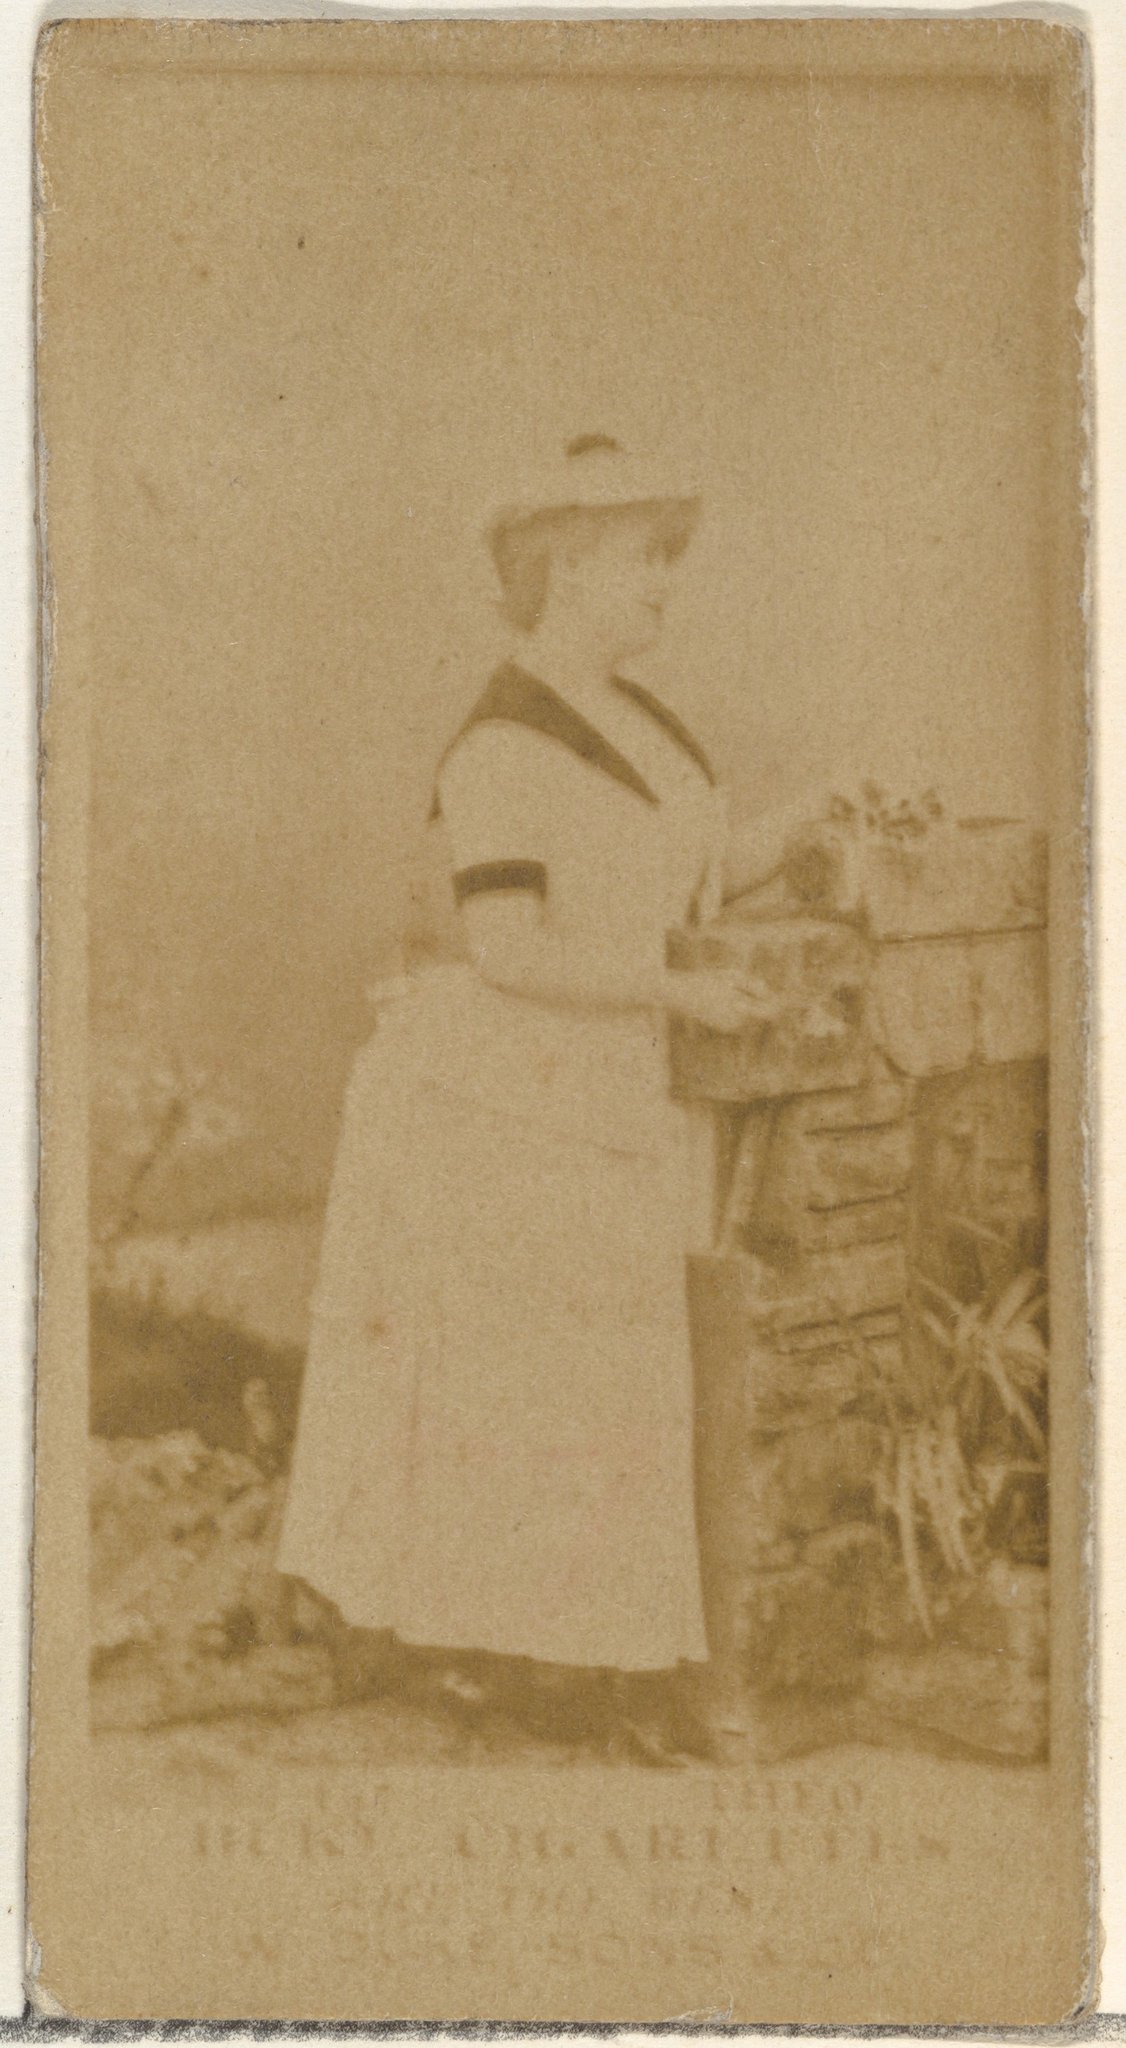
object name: photograph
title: Theo, from the Actors and Actresses series (N145-7) issued by Duke Sons & Co. to promote Duke Cigarettes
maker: w. duke, sons & co.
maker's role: publisher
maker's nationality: american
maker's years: 1870-1920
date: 1880-1889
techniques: albumen silver print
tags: women,actresses